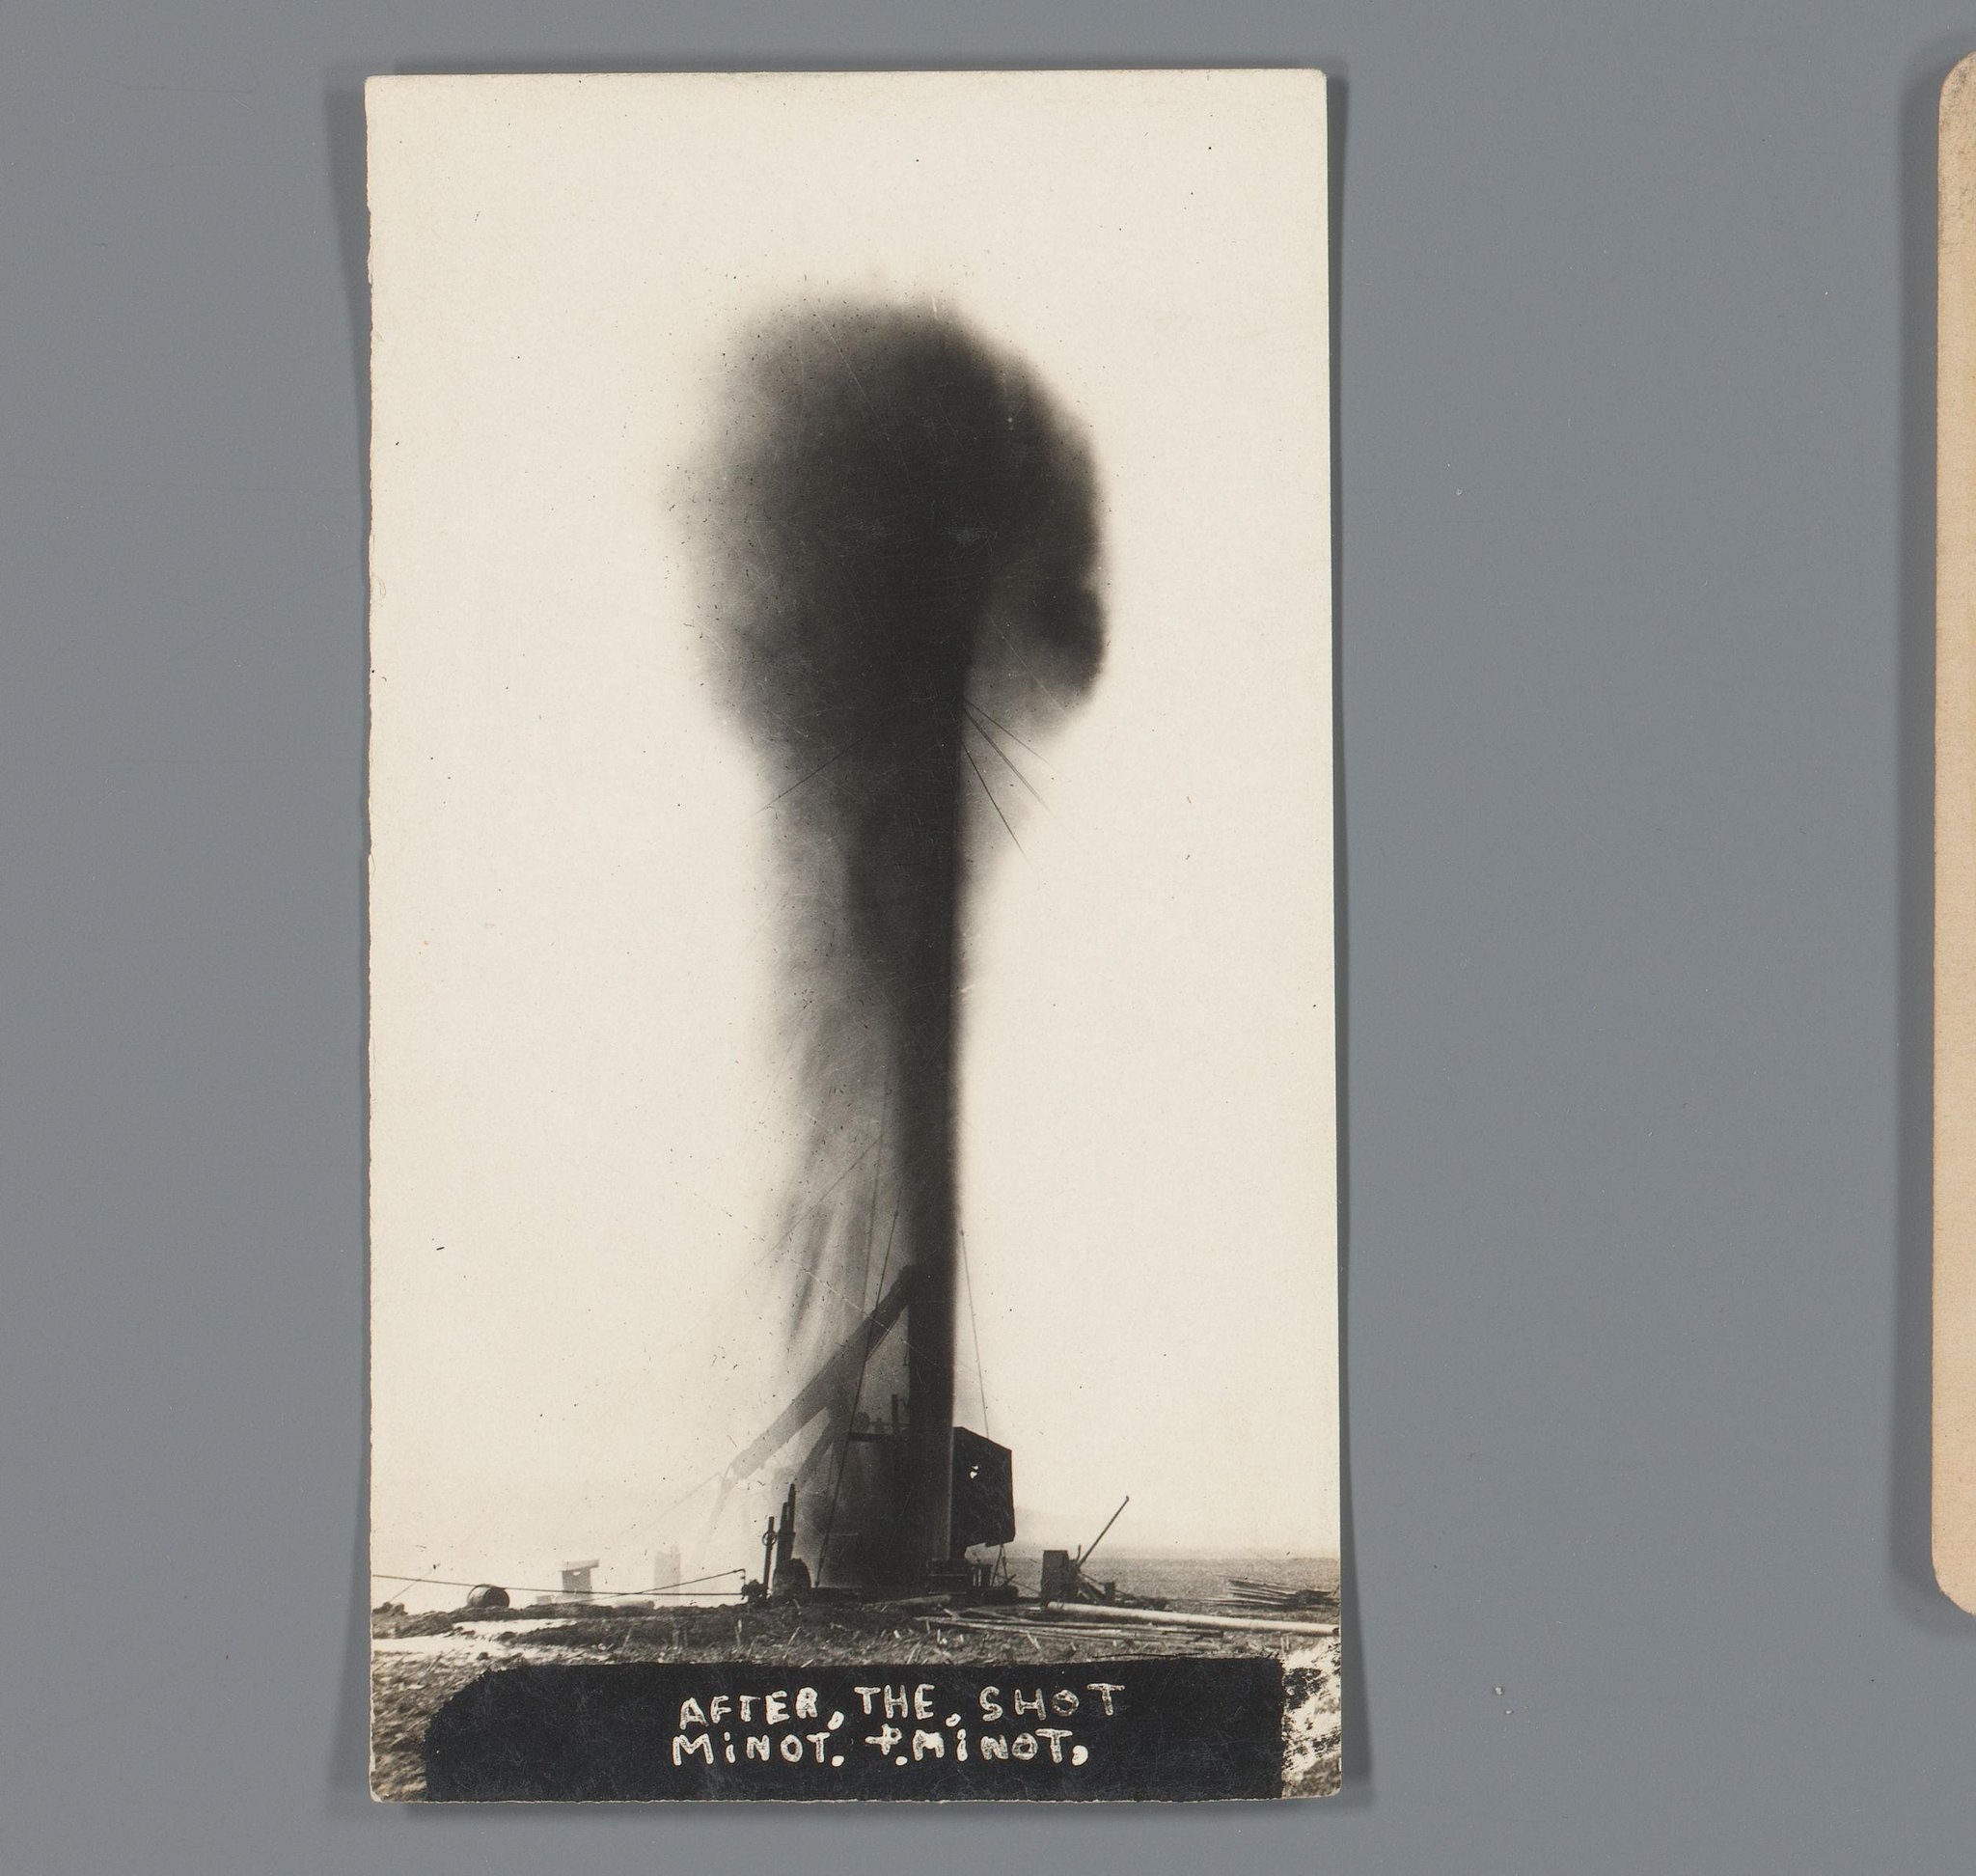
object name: photograph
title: Gezicht op een explosie in een oliebron van Minot & Minot, Tulsa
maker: Anonymous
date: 1880-1910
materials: cardboard, photographic support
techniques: gelatin silver print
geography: tulsa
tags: oil; oil refinery, projectiles, explosives, etc.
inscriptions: inscription: ‘AFTER THE SHOT / MINOT & MINOT’, stamp: ‘COMPLIMENTS OF / MINOT & MINOT / Oil Producers / TULSA, OKLA.’